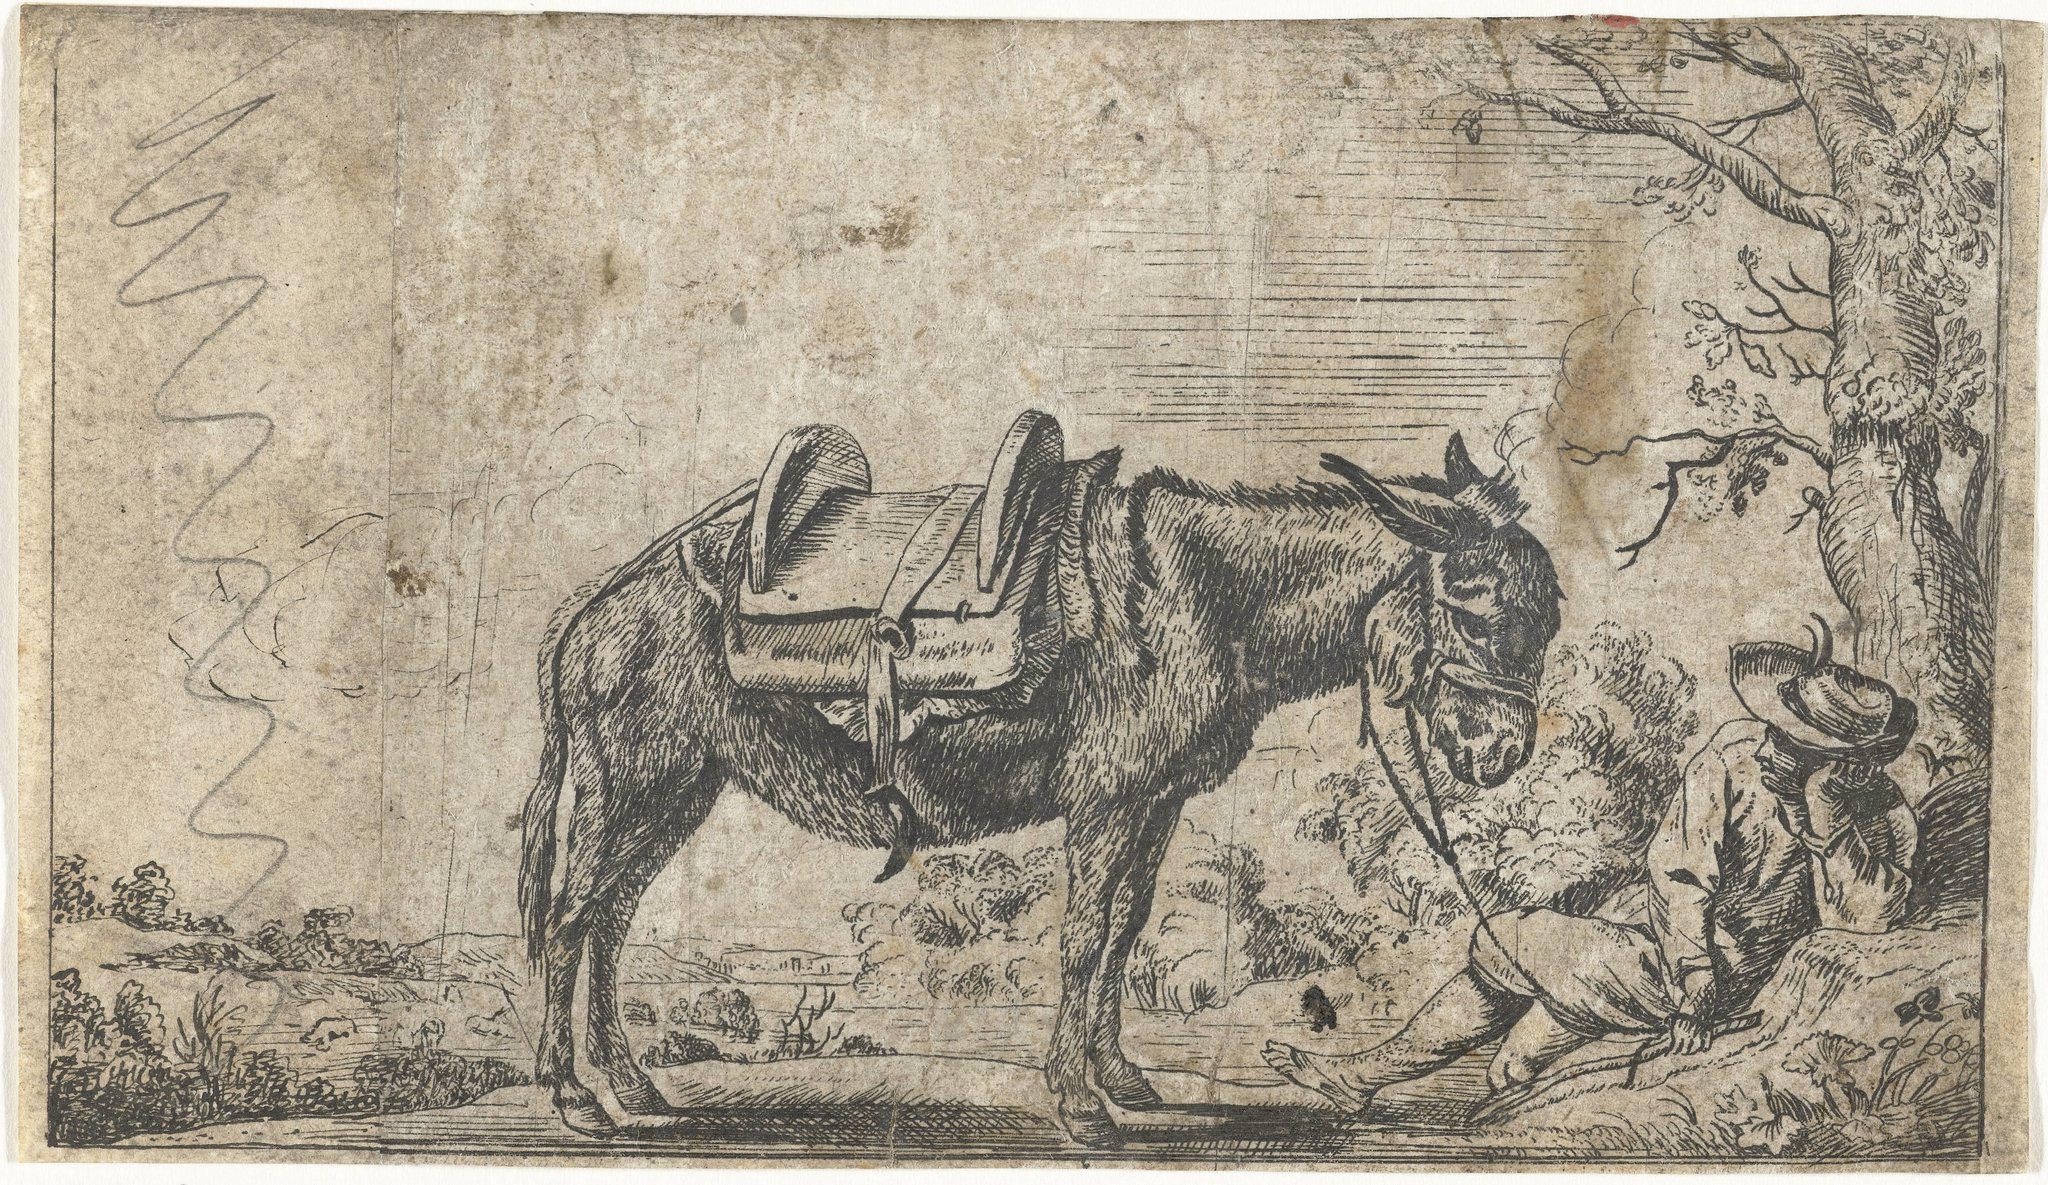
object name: print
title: Man met ezel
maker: Anonymous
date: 1630-1680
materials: paper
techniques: etching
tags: ass, donkey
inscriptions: collector's mark: Lugt 2228